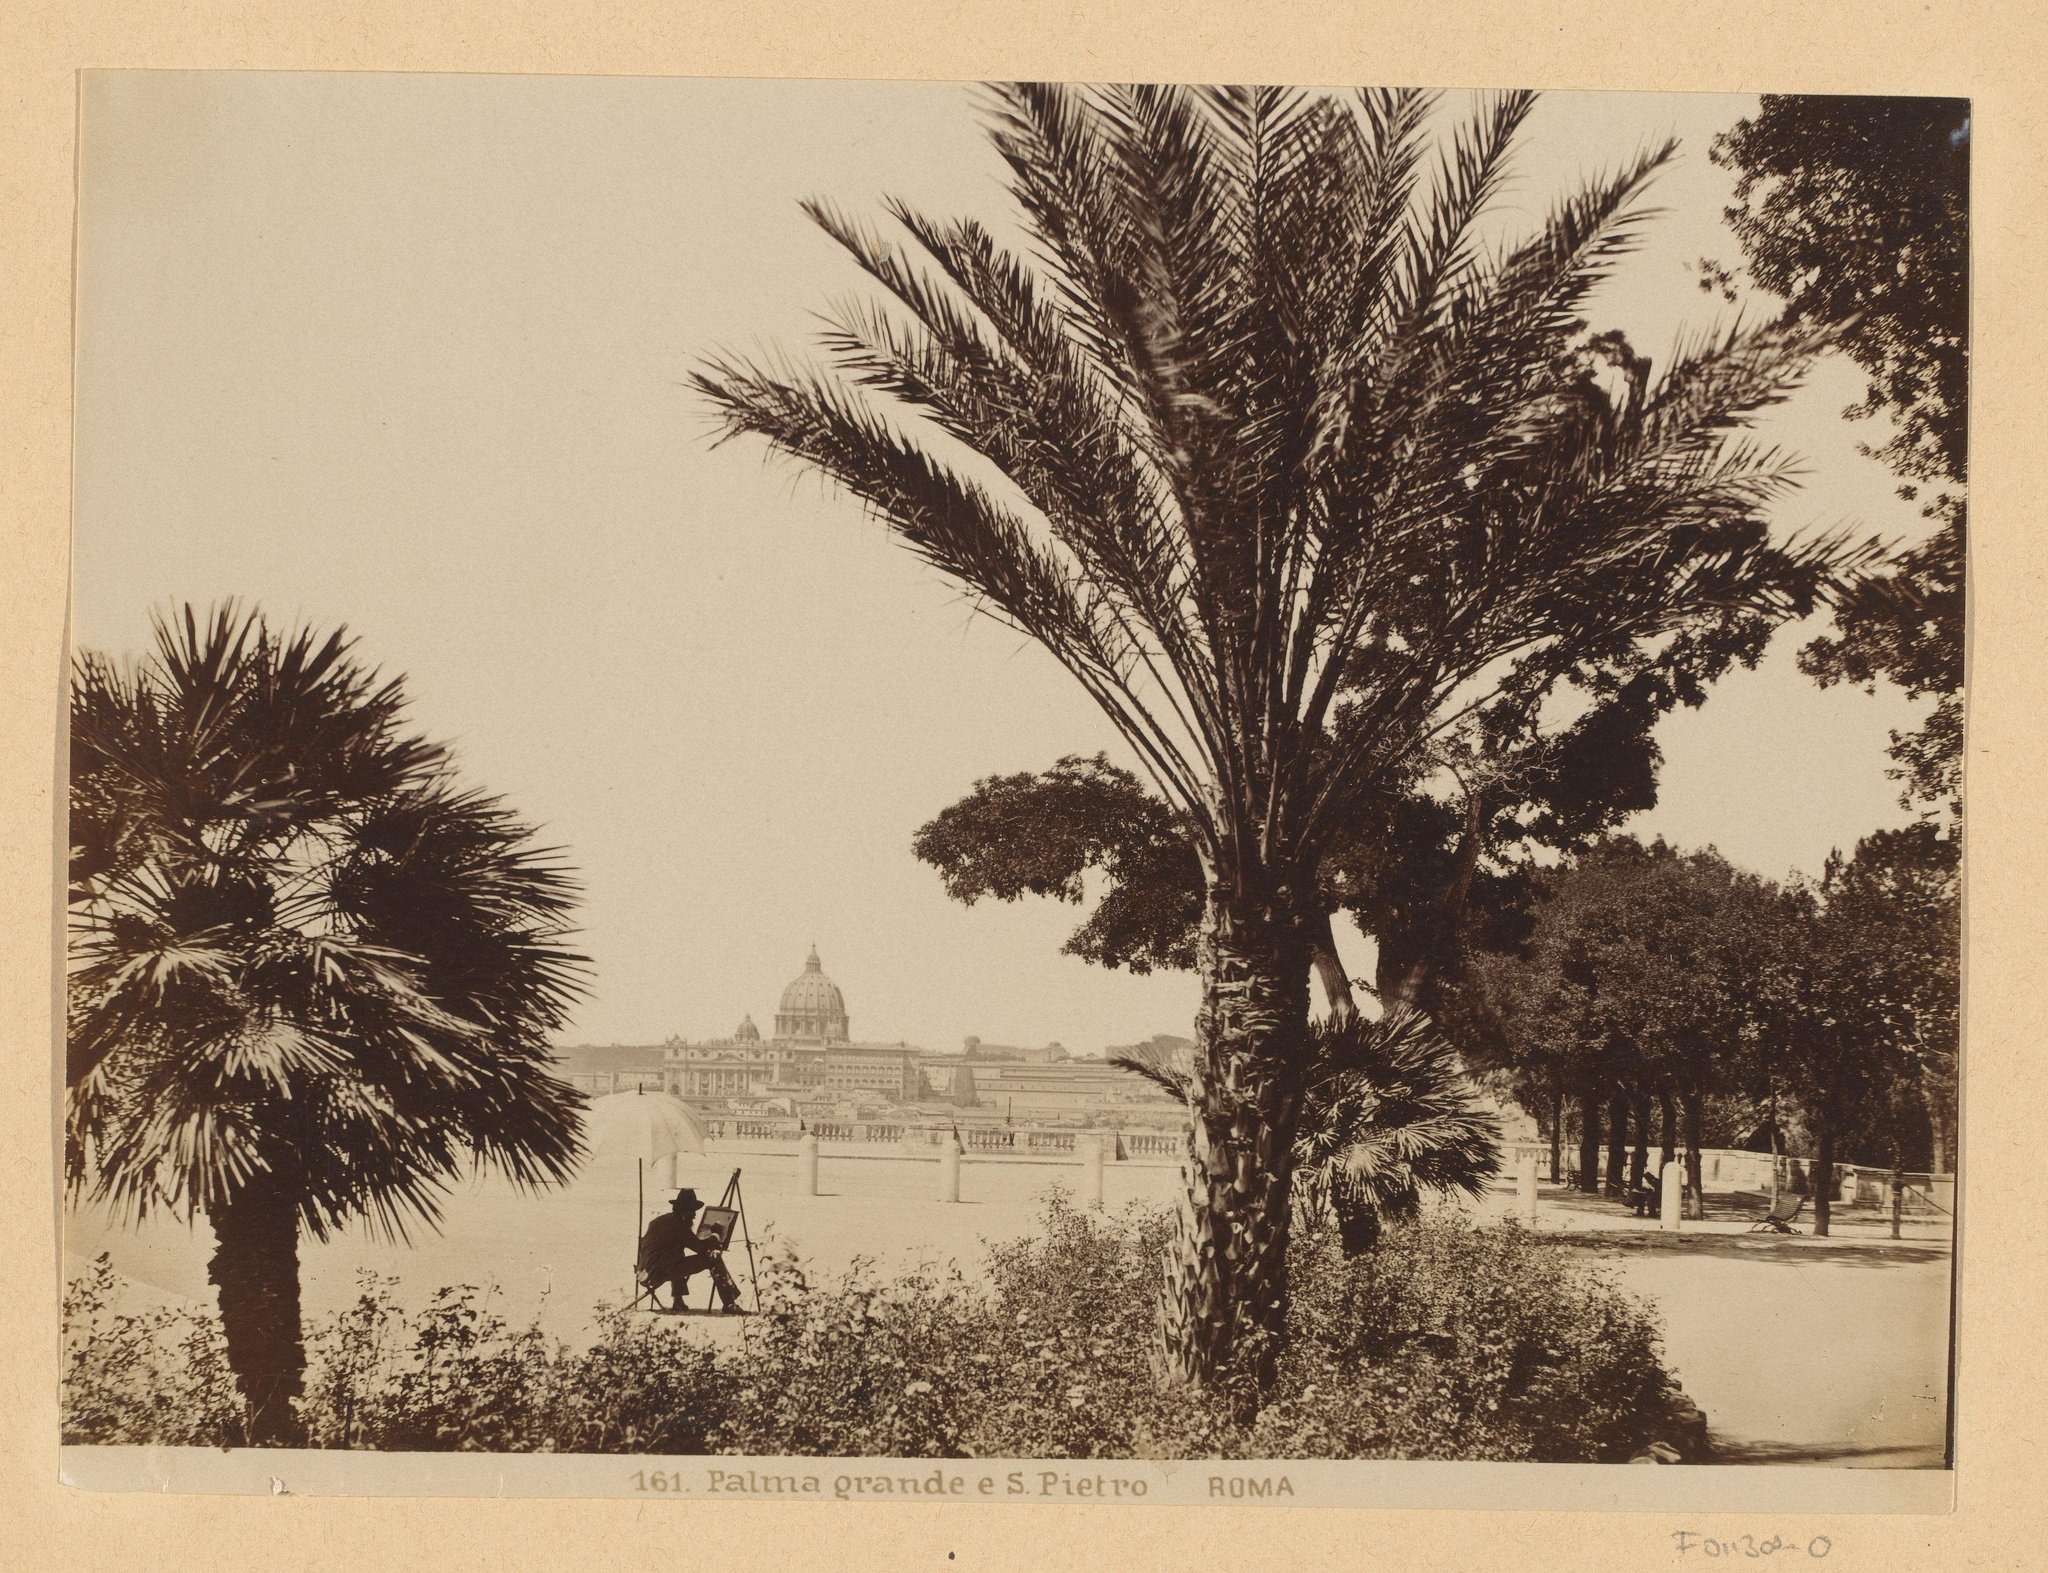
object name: photograph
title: Gezicht op de Sint-Pietersbasiliek in Rome met op de voorgrond een schilder aan het werk naast een palm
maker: Anonymous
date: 1860-1900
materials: photographic support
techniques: albumen print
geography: rome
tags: church (exterior), trees: palm-tree, painter at work, in his studio - cc - out of doors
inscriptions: number: ‘161’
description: Onderdeel van Reisalbum met opnames van kunstwerken en bezienswaardigheden in Italië, Griekenland en Frankrijk.